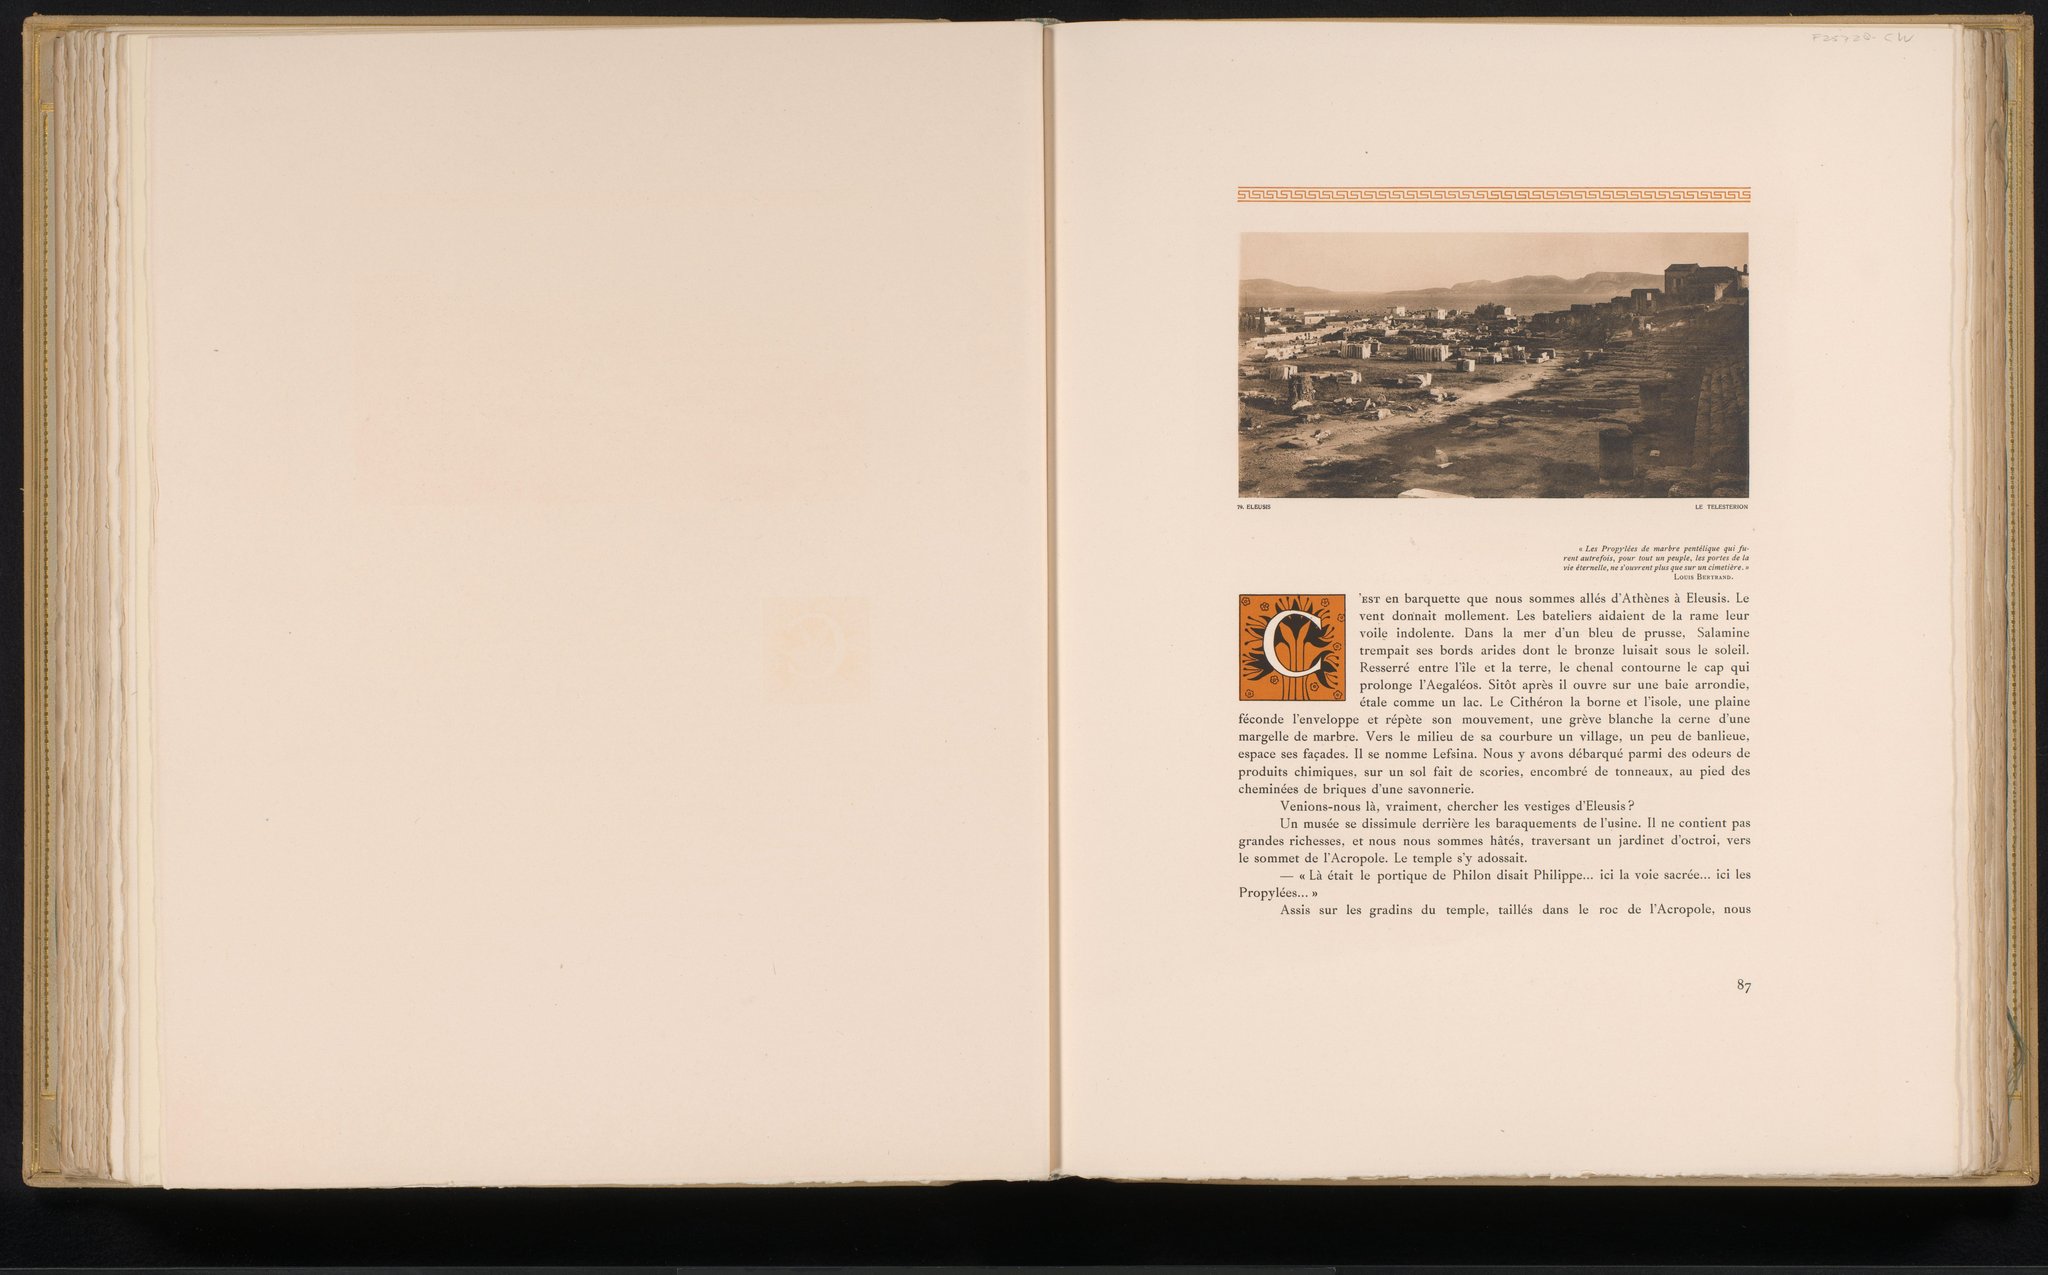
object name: page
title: Eleusis, le Telesterion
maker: frédéric boissonnas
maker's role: fotograaf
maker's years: 1858-1946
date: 1905-1910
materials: paper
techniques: photograph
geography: berlin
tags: landscape with ruins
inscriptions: number: ‘79.’